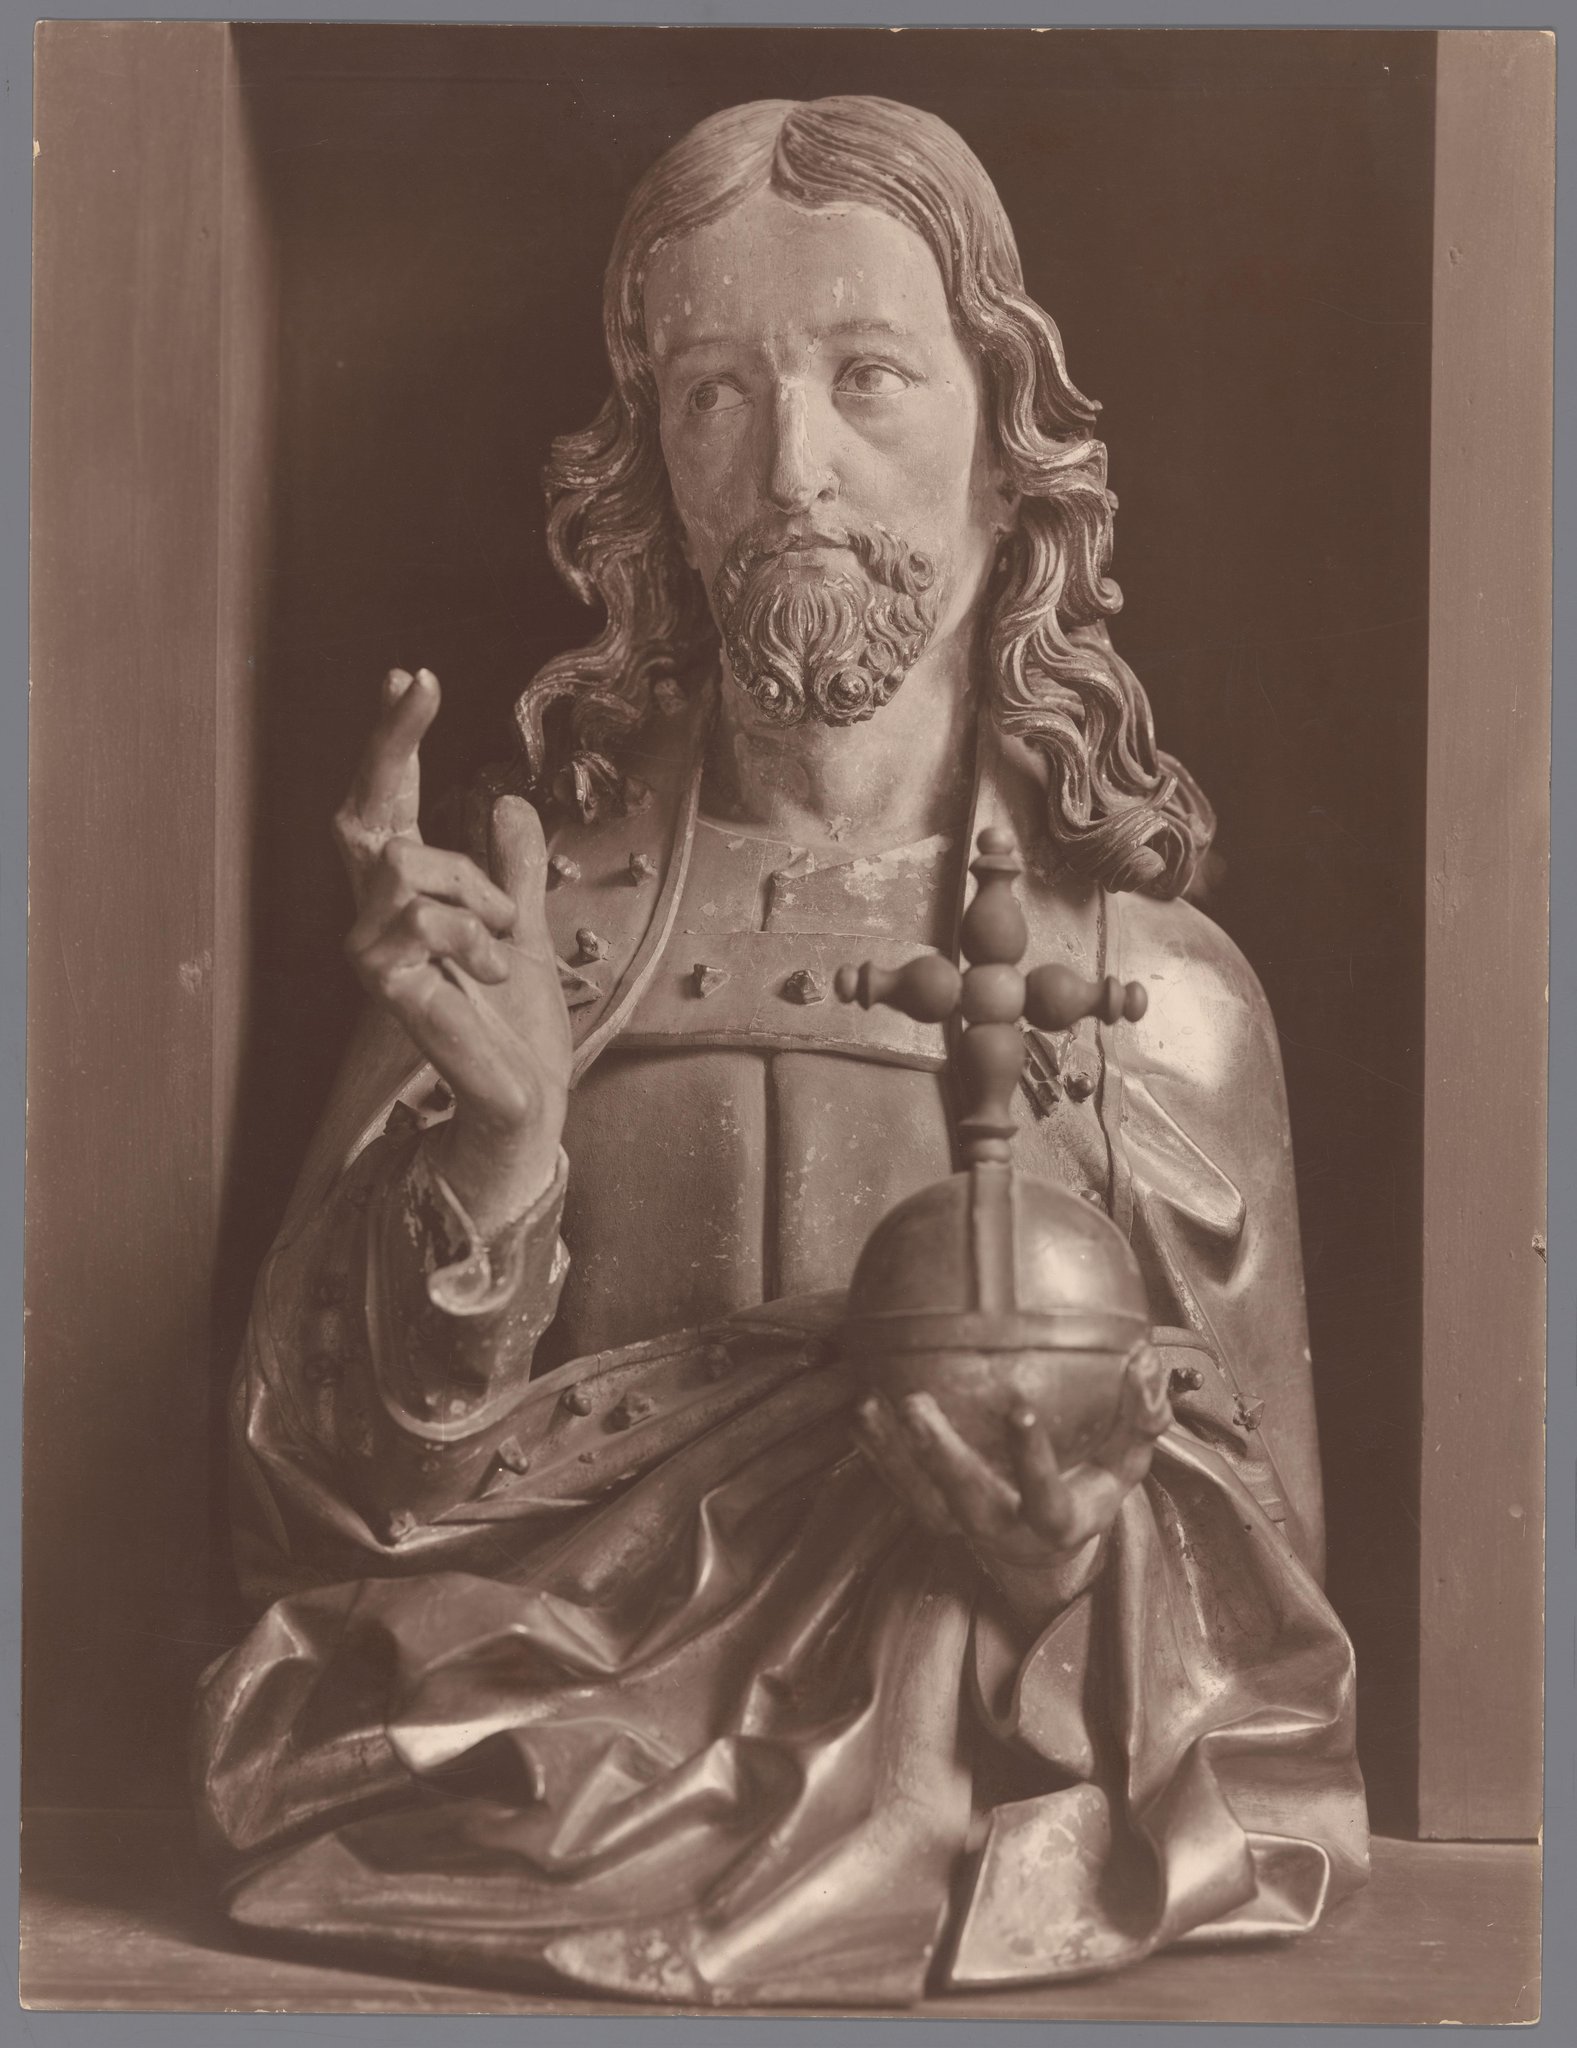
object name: photograph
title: Gezicht op een buste van Christus die met de ene hand een zegenend gebaar maakt en in de andere hand een rijksappel draagt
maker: j. christophe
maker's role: fotograaf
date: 1900-1960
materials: photographic support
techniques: gelatin silver print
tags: orb (symbol of sovereignty; sphere with cross on top), christ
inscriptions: stamp: ‘Reproduction Interdite’